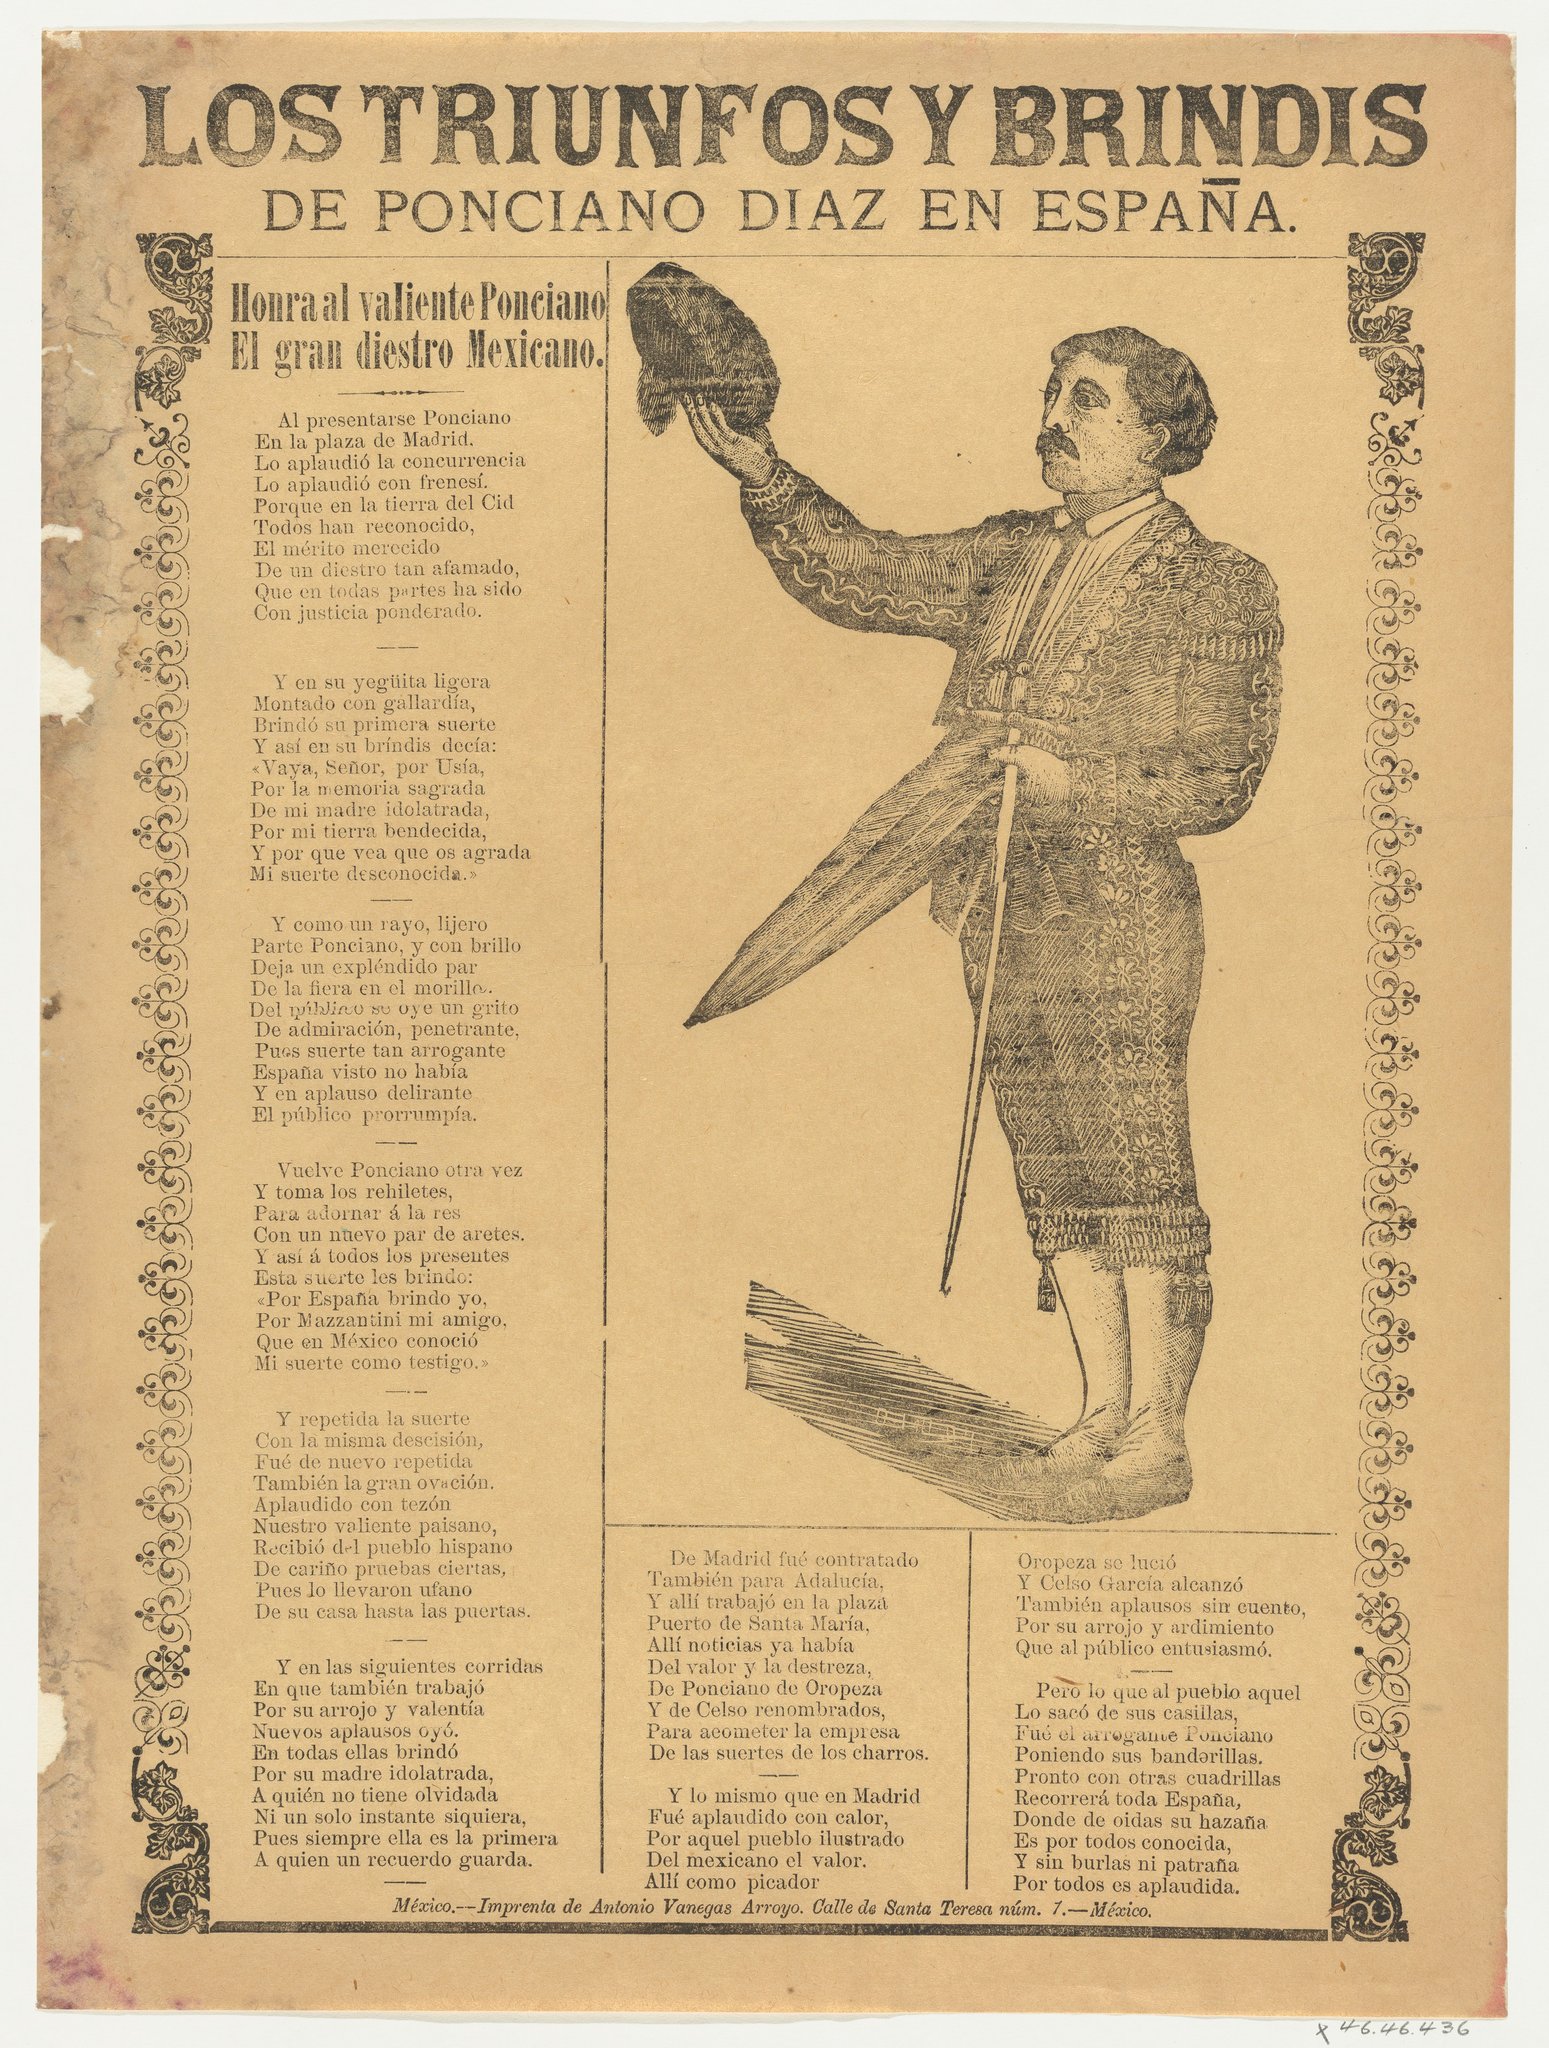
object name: print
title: Broadsheet relating to the triumphs of the bullfighter Ponciano Diaz in Spain, a corrido (ballad) in the bottom section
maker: josé guadalupe posada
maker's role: artist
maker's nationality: mexican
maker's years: 1852-1913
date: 1899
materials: paper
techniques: letterpress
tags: men